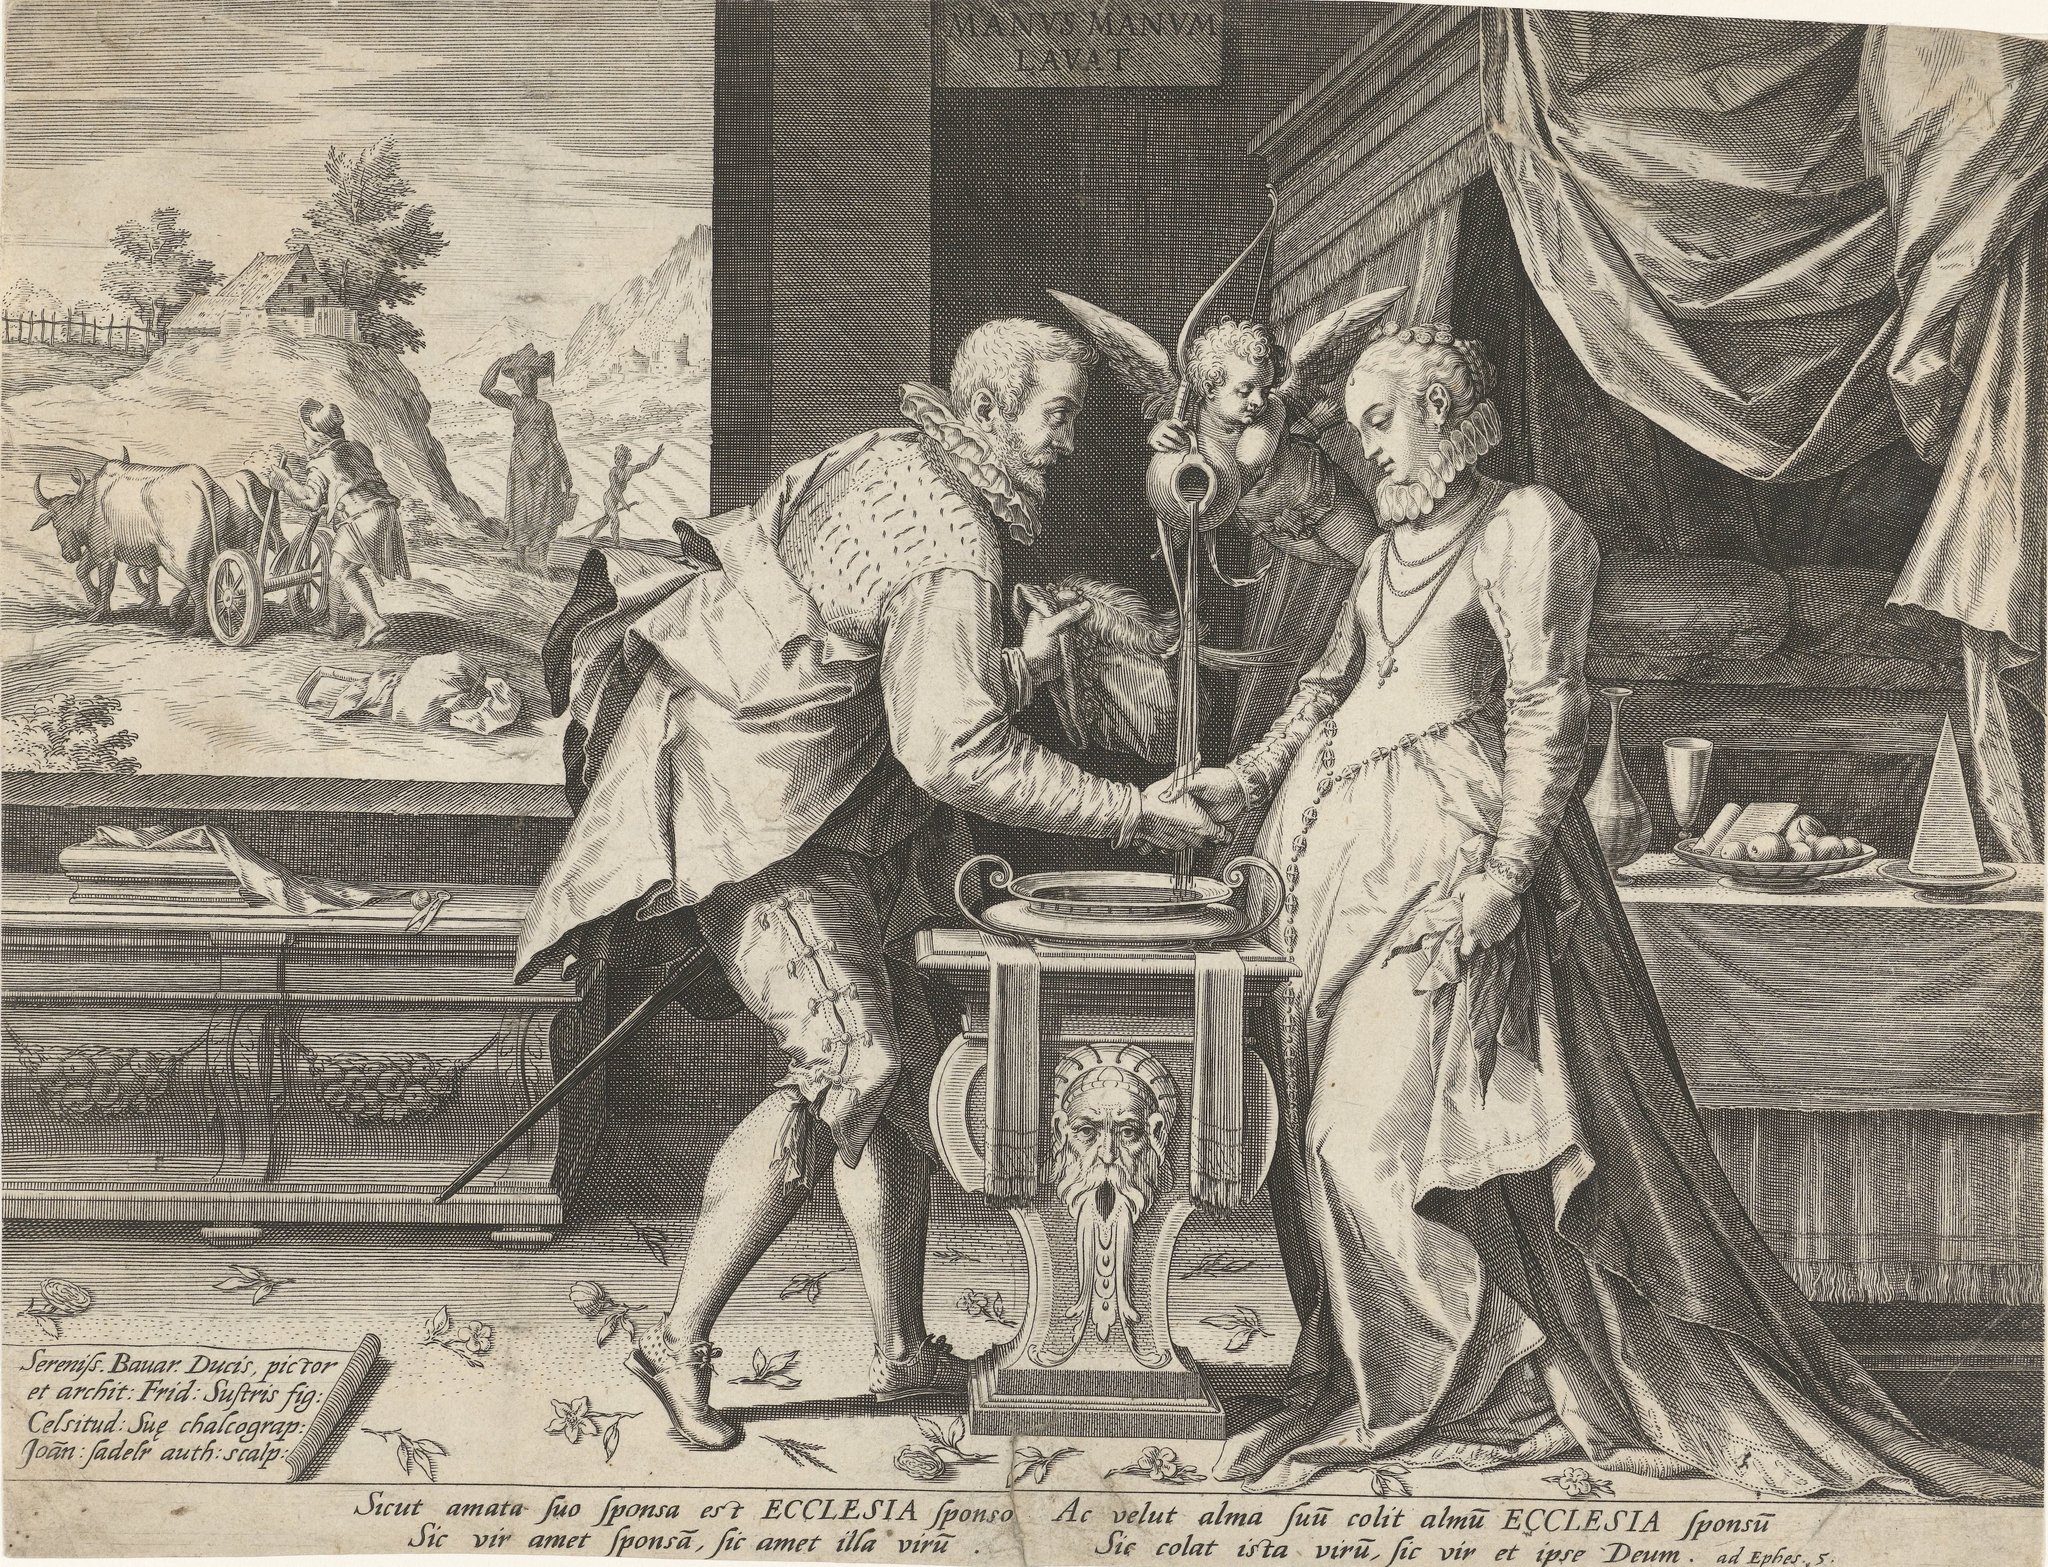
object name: print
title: Allegorie op het huwelijk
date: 1588-1595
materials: paper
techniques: engraving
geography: munich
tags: civil marriage ceremony, shaking hands, 'dextrarum junctio', epistle of paul to the ephesians (+ donor(s), supplicant(s), whether or not with patron saint(s)), bed with tester, (personifications and symbolic representations of) love; 'amore (secondo seneca)' (ripa), (story of) cupid, amor (eros), 'benevolenza et unione matrimoniale', 'concordia maritale' (ripa), ploughing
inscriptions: collector's mark: Lugt 2228, number: ‘no. 2037’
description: Cupido giet water uit over de handen van een man en vrouw die tegenover elkaar staan. Rechtsachter in het vertrek een hemelbed. Links door het venster is een ploegende boer te zien. De prent heeft een Latijns onderschrift met een Bijbelcitaat over het huwelijk (Ef. 5).